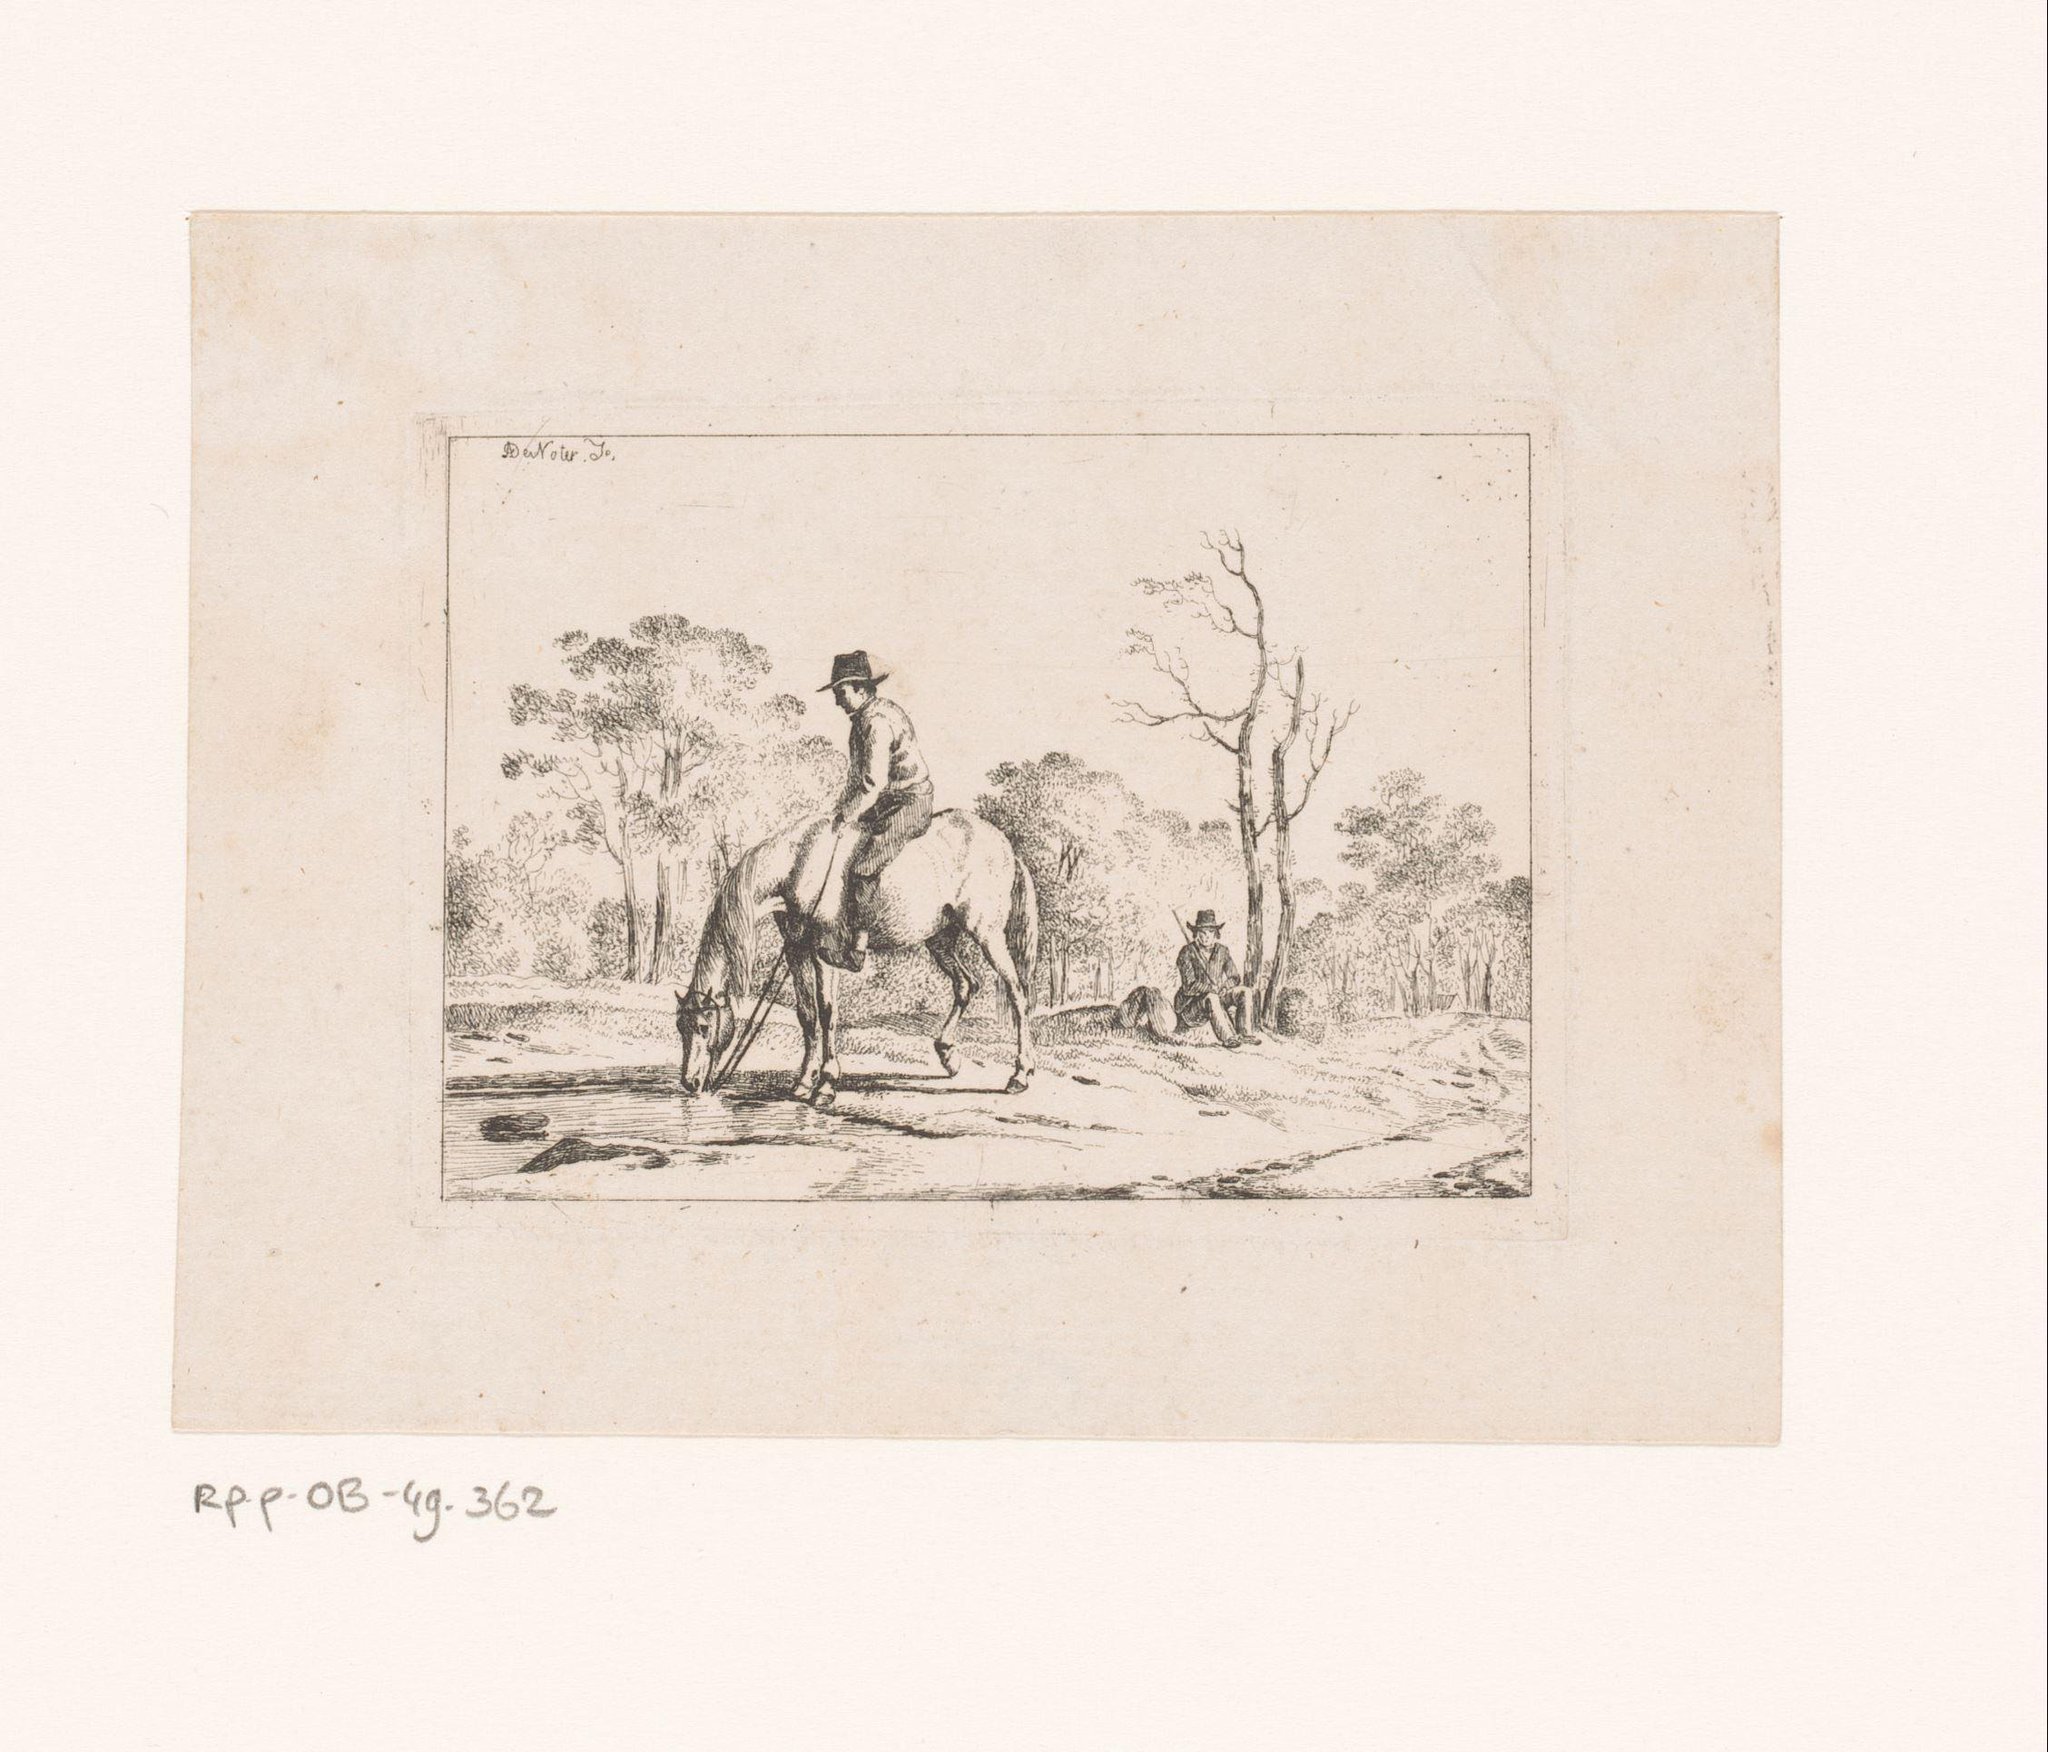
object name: print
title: Landschap met ruiter op een drinkend paard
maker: auguste herman marie de noter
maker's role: print maker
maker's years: 1806-1838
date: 1829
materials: paper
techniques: etching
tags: riding a horse, ass, or mule; rider, horseman, horse, landscapes with waters, waterscapes, seascapes (in the temperate zone) (+ landscape with figures, staffage)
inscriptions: collector's mark: Lugt 2228